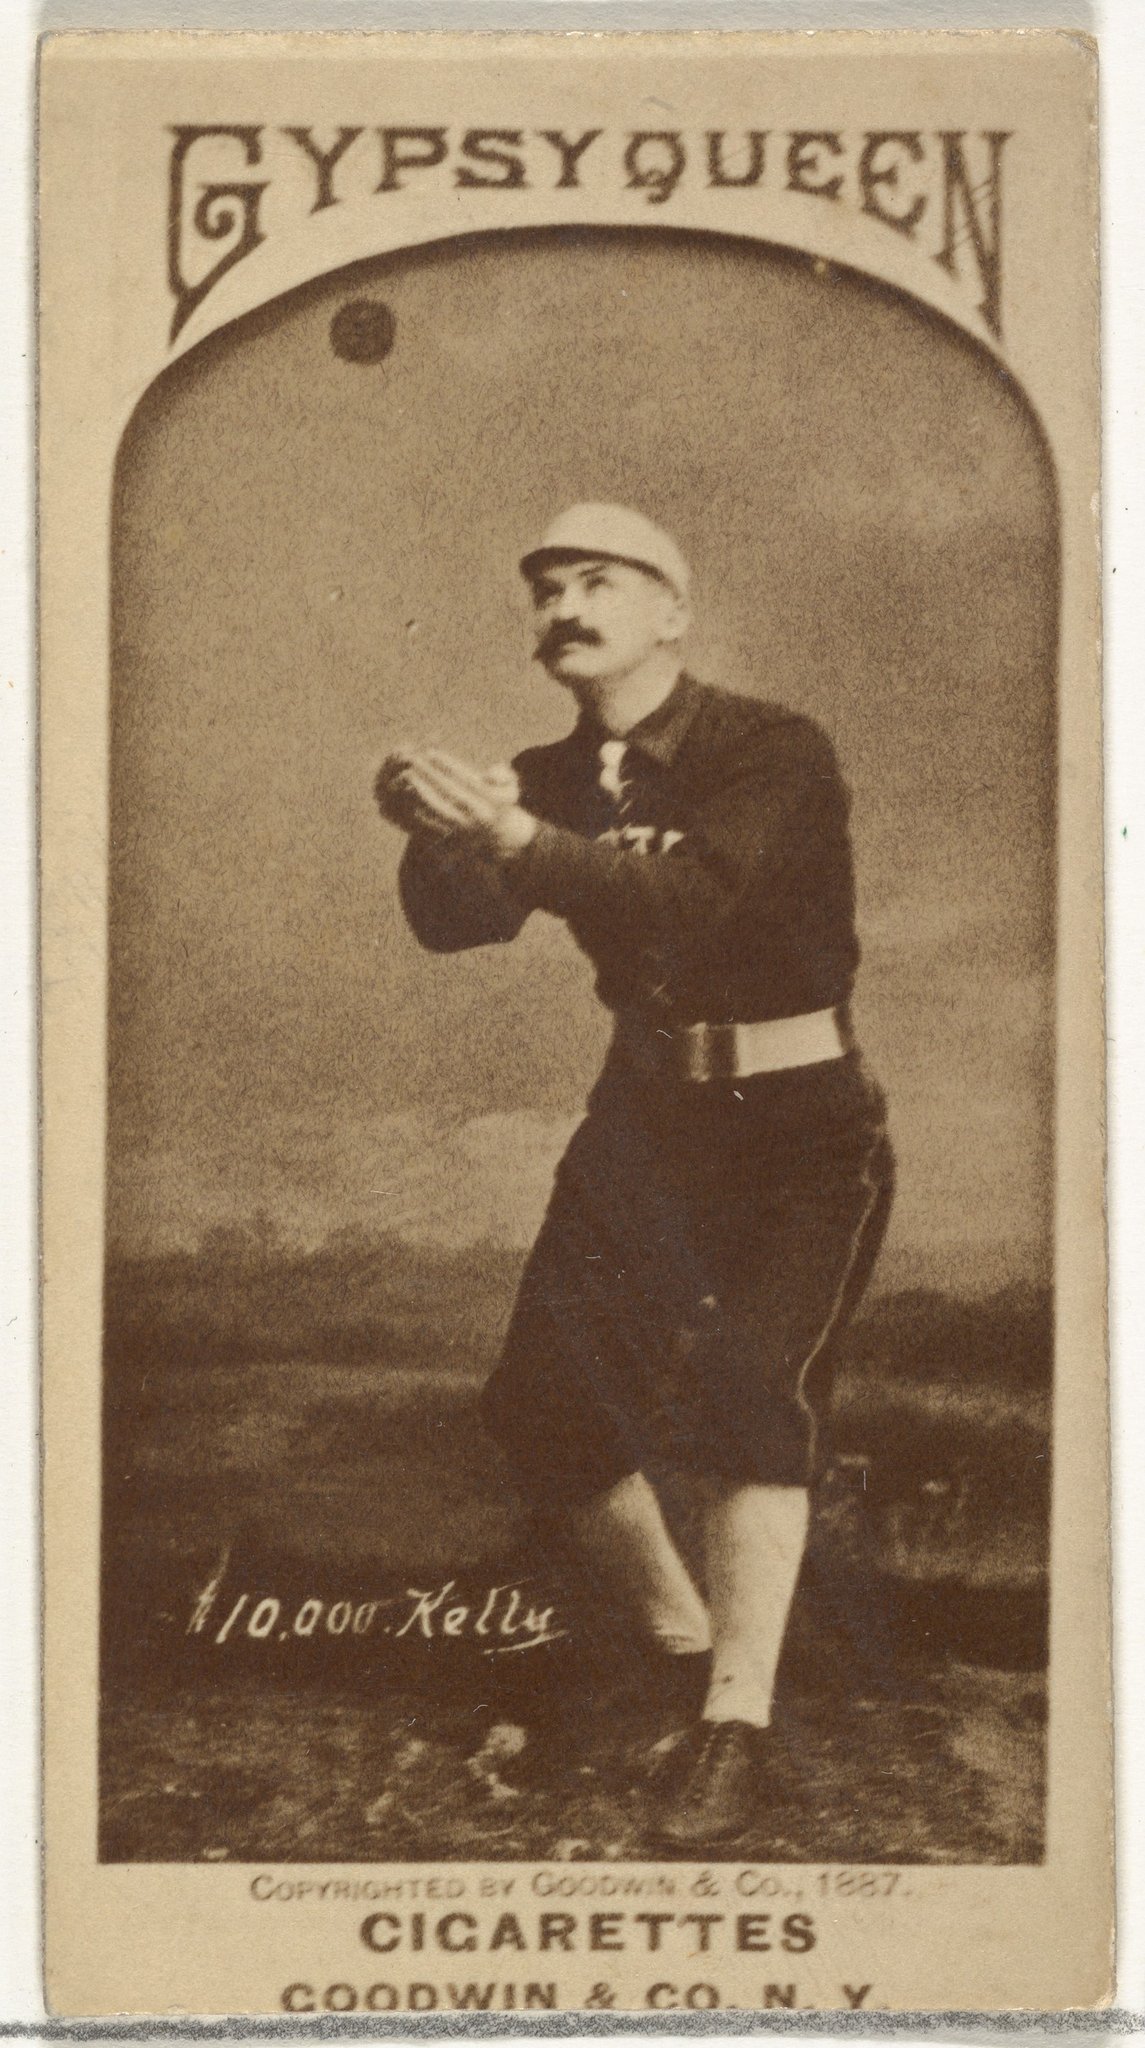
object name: baseball card, photograph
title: Michael Joseph "$10,000" Kelly, from the Old Judge series (N172) for Old Judge and Gypsy Queen Cigarettes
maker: goodwin & company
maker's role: publisher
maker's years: 1850-1950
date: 1887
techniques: albumen silver print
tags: men,portraits,baseball,athletes